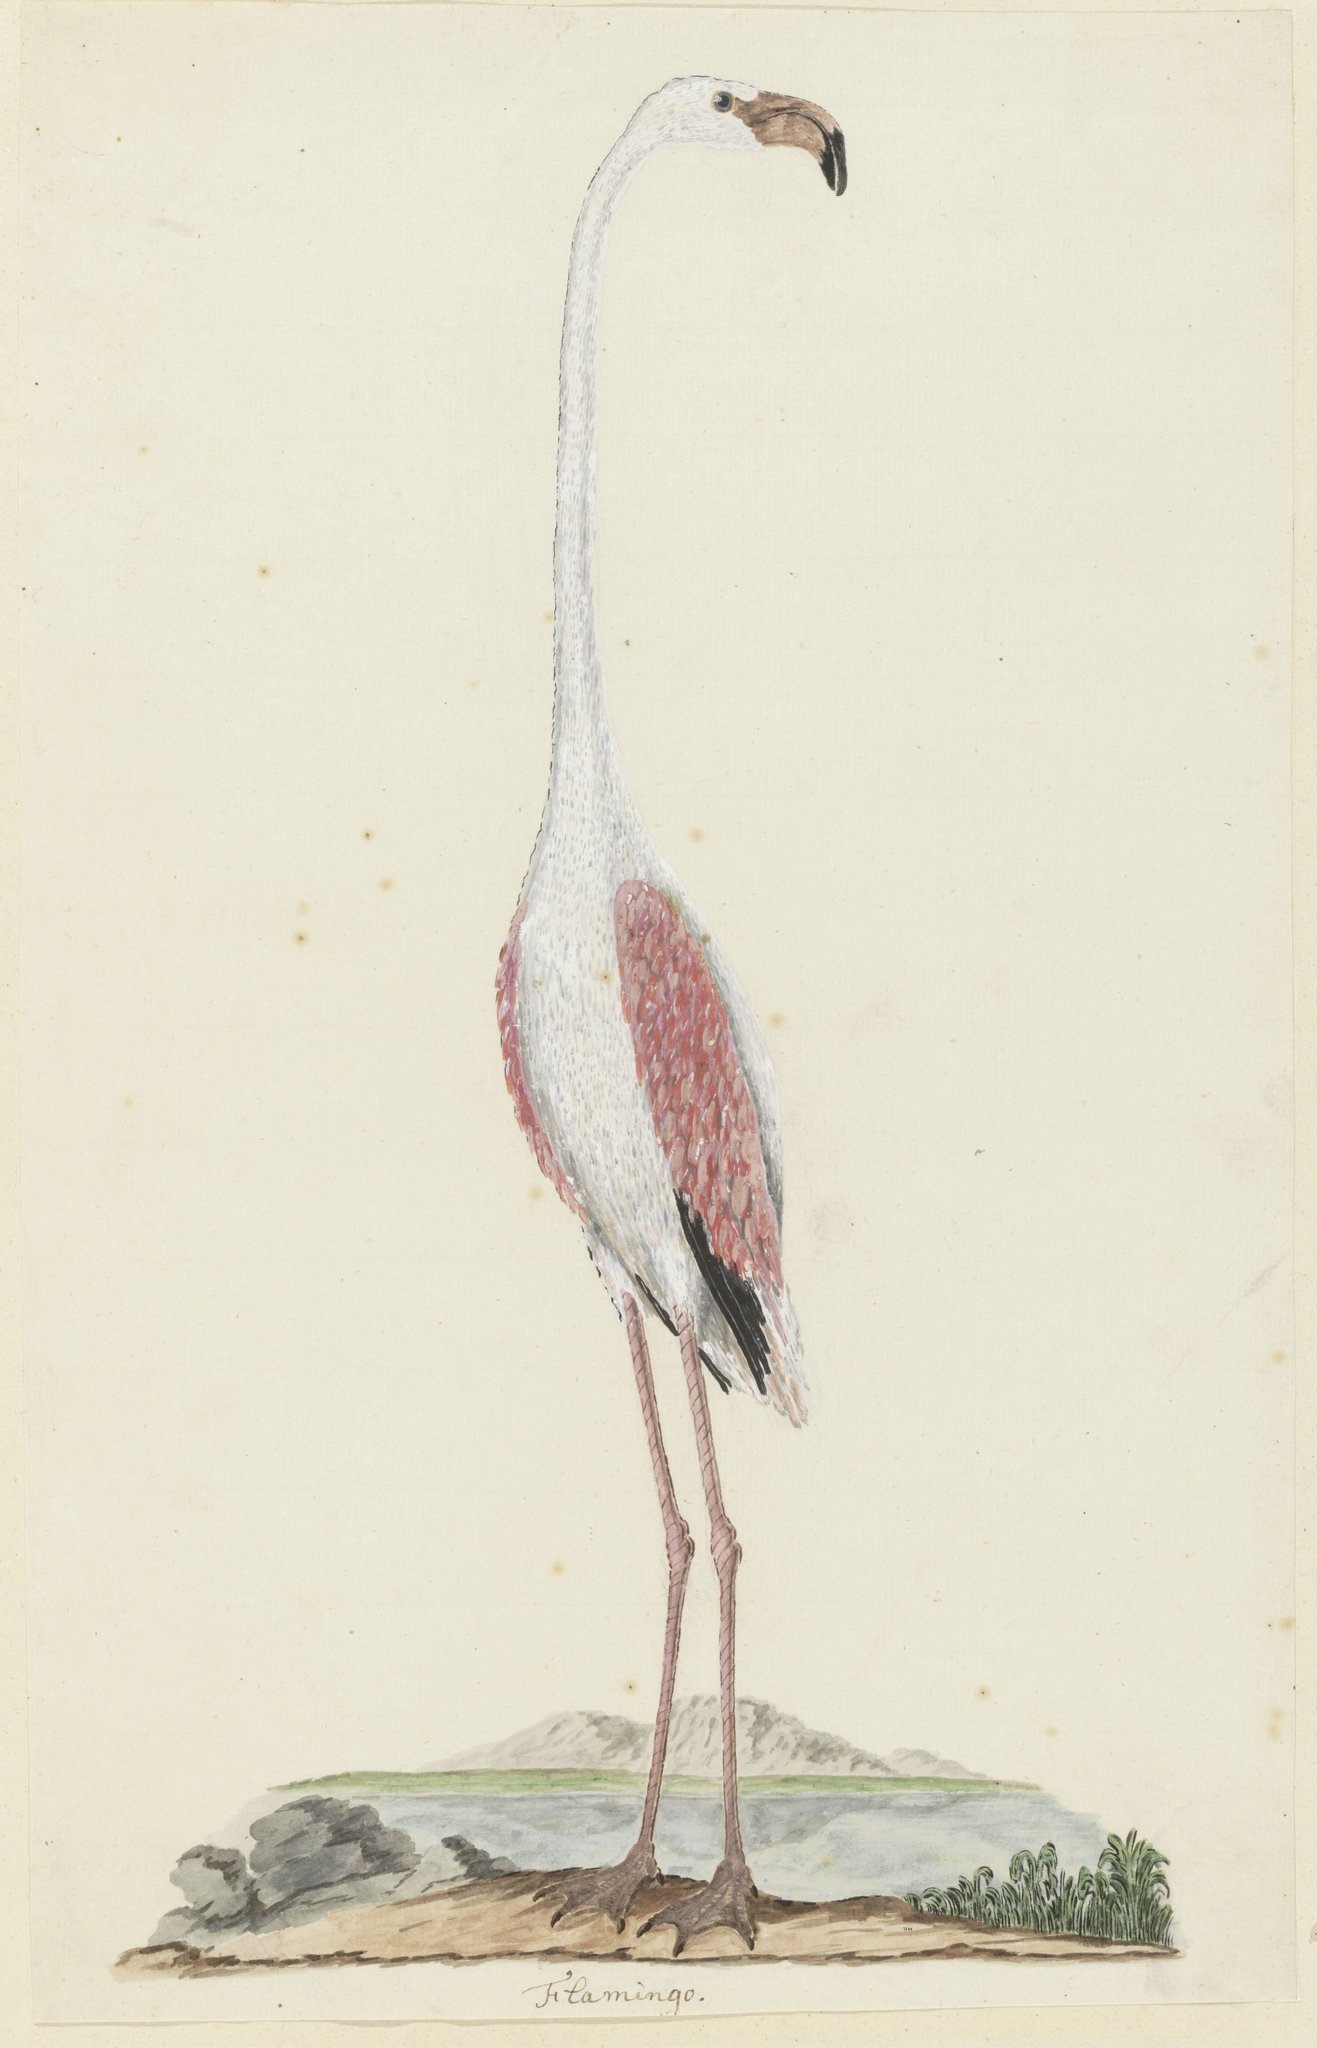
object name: album leaf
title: Phoenicopterus ruber roseus (Greater flamingo)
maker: robert jacob gordon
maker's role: draughtsman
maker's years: 1743-1795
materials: chalk, paint, ink, paper, pencil, watercolor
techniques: brush, pen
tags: shore-birds and wading-birds: flamingo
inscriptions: annotation: ‘Flamingo.’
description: Vogelstudie: Grote flamingo (Phoenicopterus ruber).